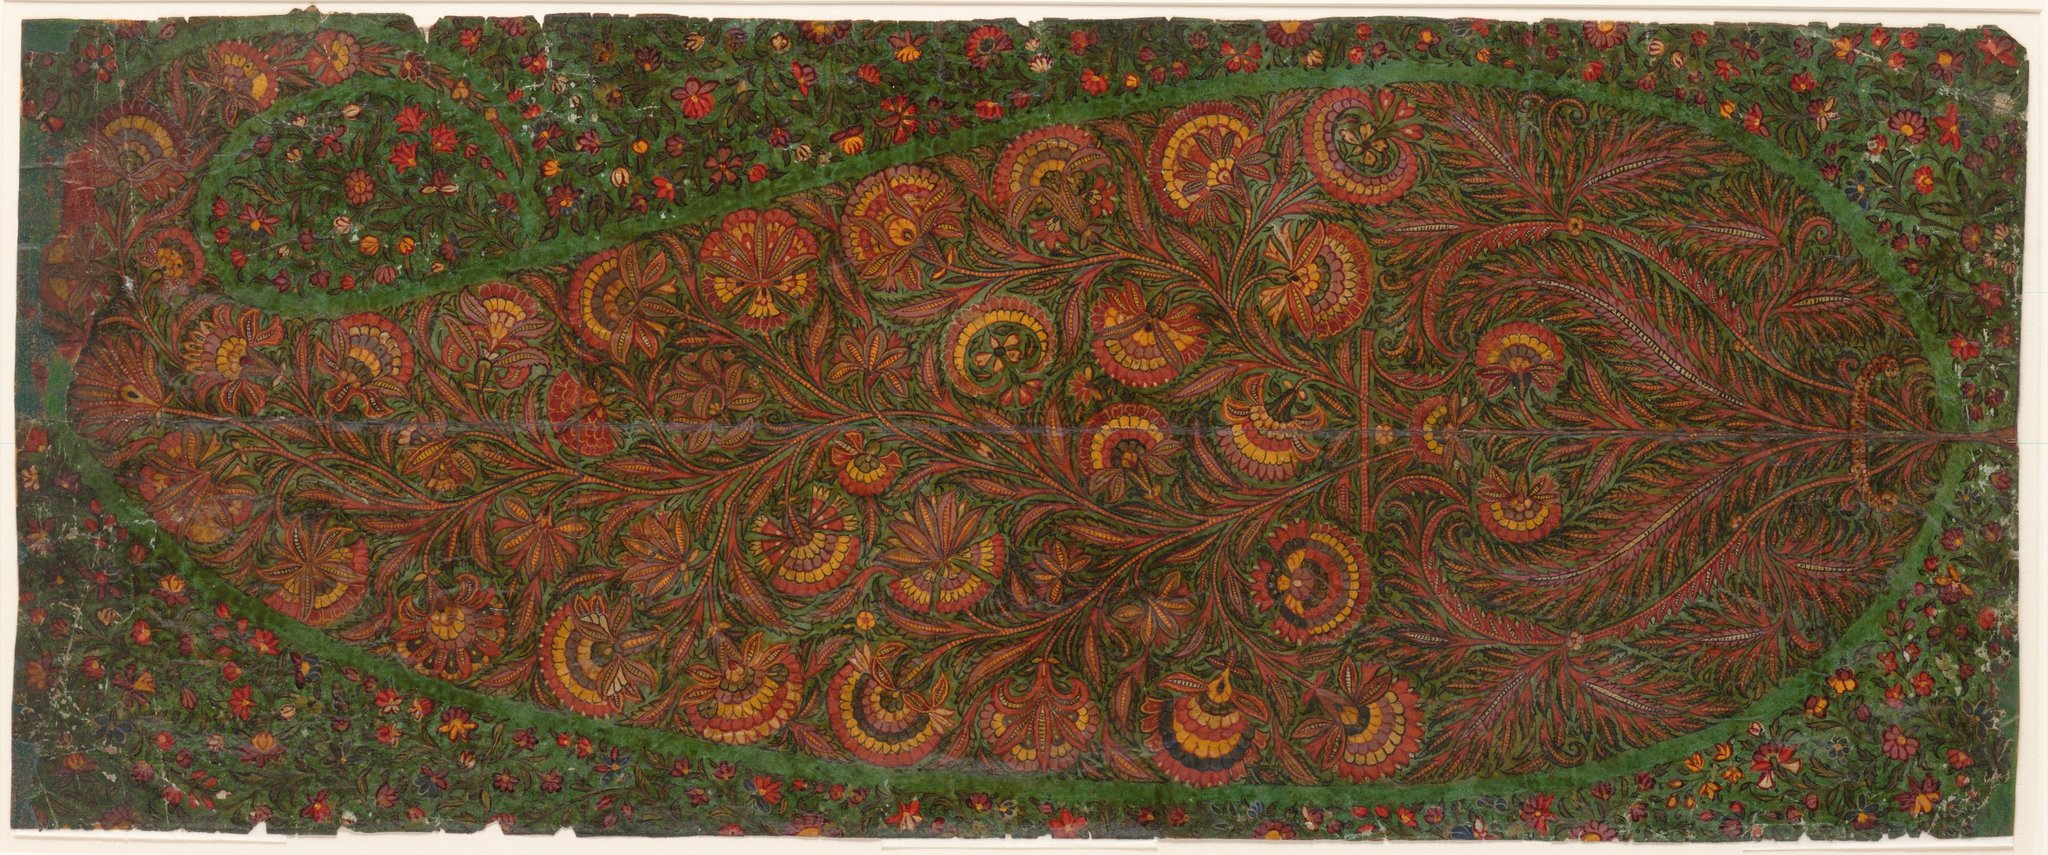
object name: drawing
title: Motif from Kashmir Shawl: Pheerozee (Turquoise Color), No. 23, By Order of Mahummud Azeem Khan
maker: anonymous, indian, 19th century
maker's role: artist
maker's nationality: indian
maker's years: 1800-1900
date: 1822-1823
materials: gouache, paper, varnish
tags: flowers